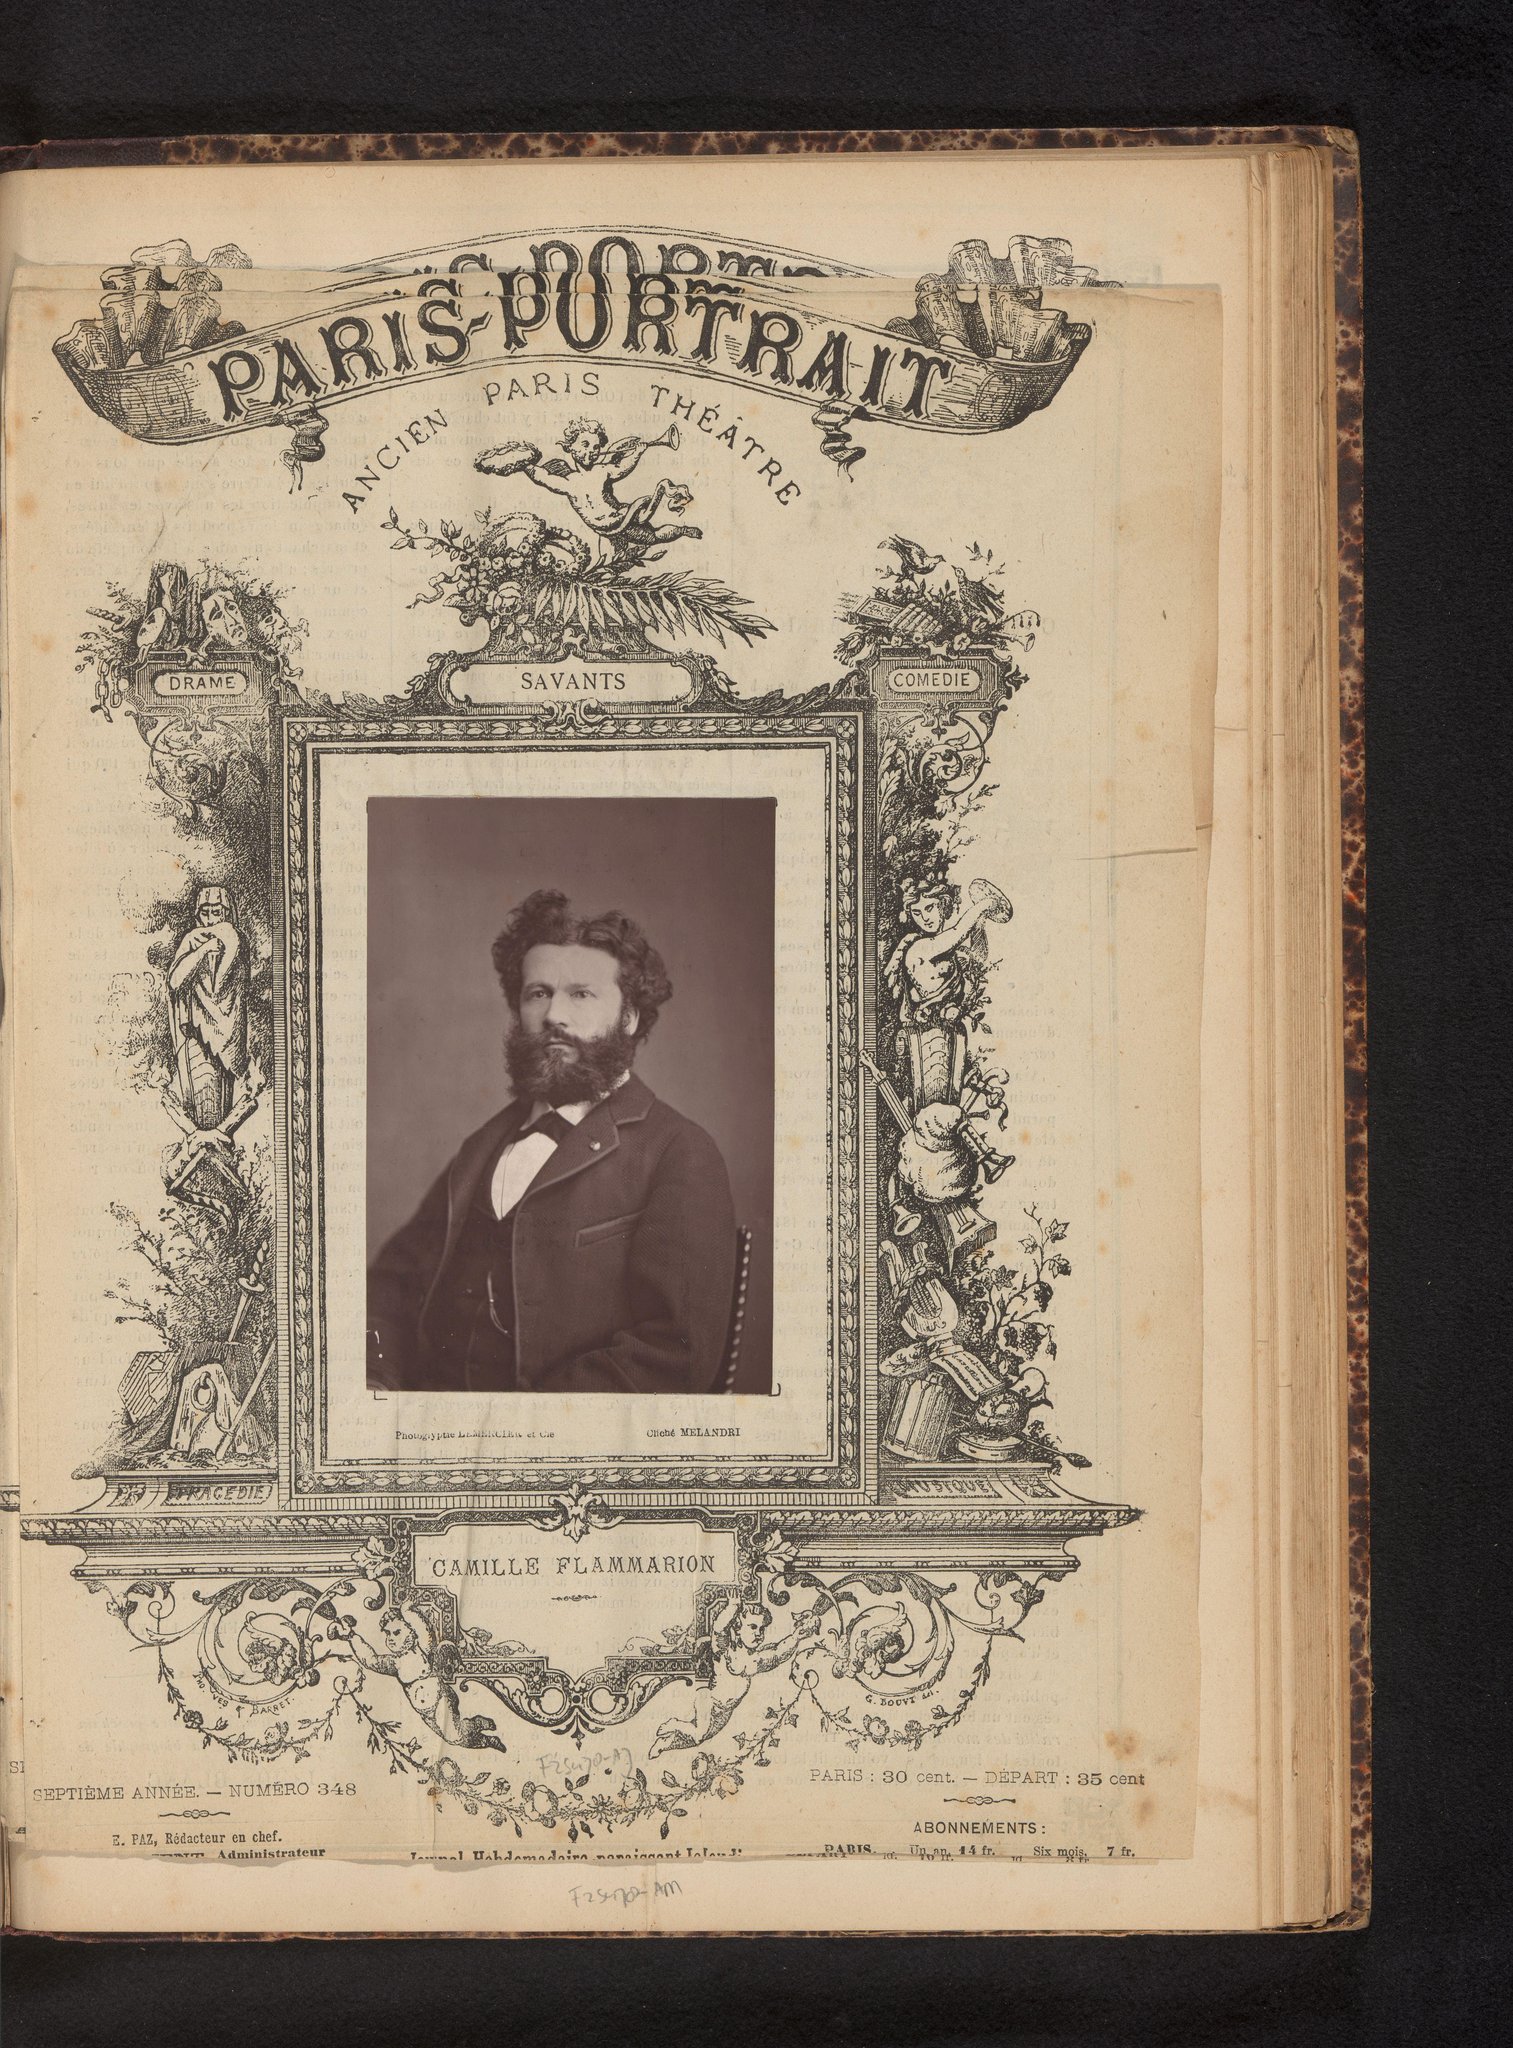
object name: photomechanical print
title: Camille Flammarion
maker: achille mélandri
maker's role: publisher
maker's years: 1845-1905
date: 1873-1880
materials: paper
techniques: woodburytype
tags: camille flammarion, historical persons